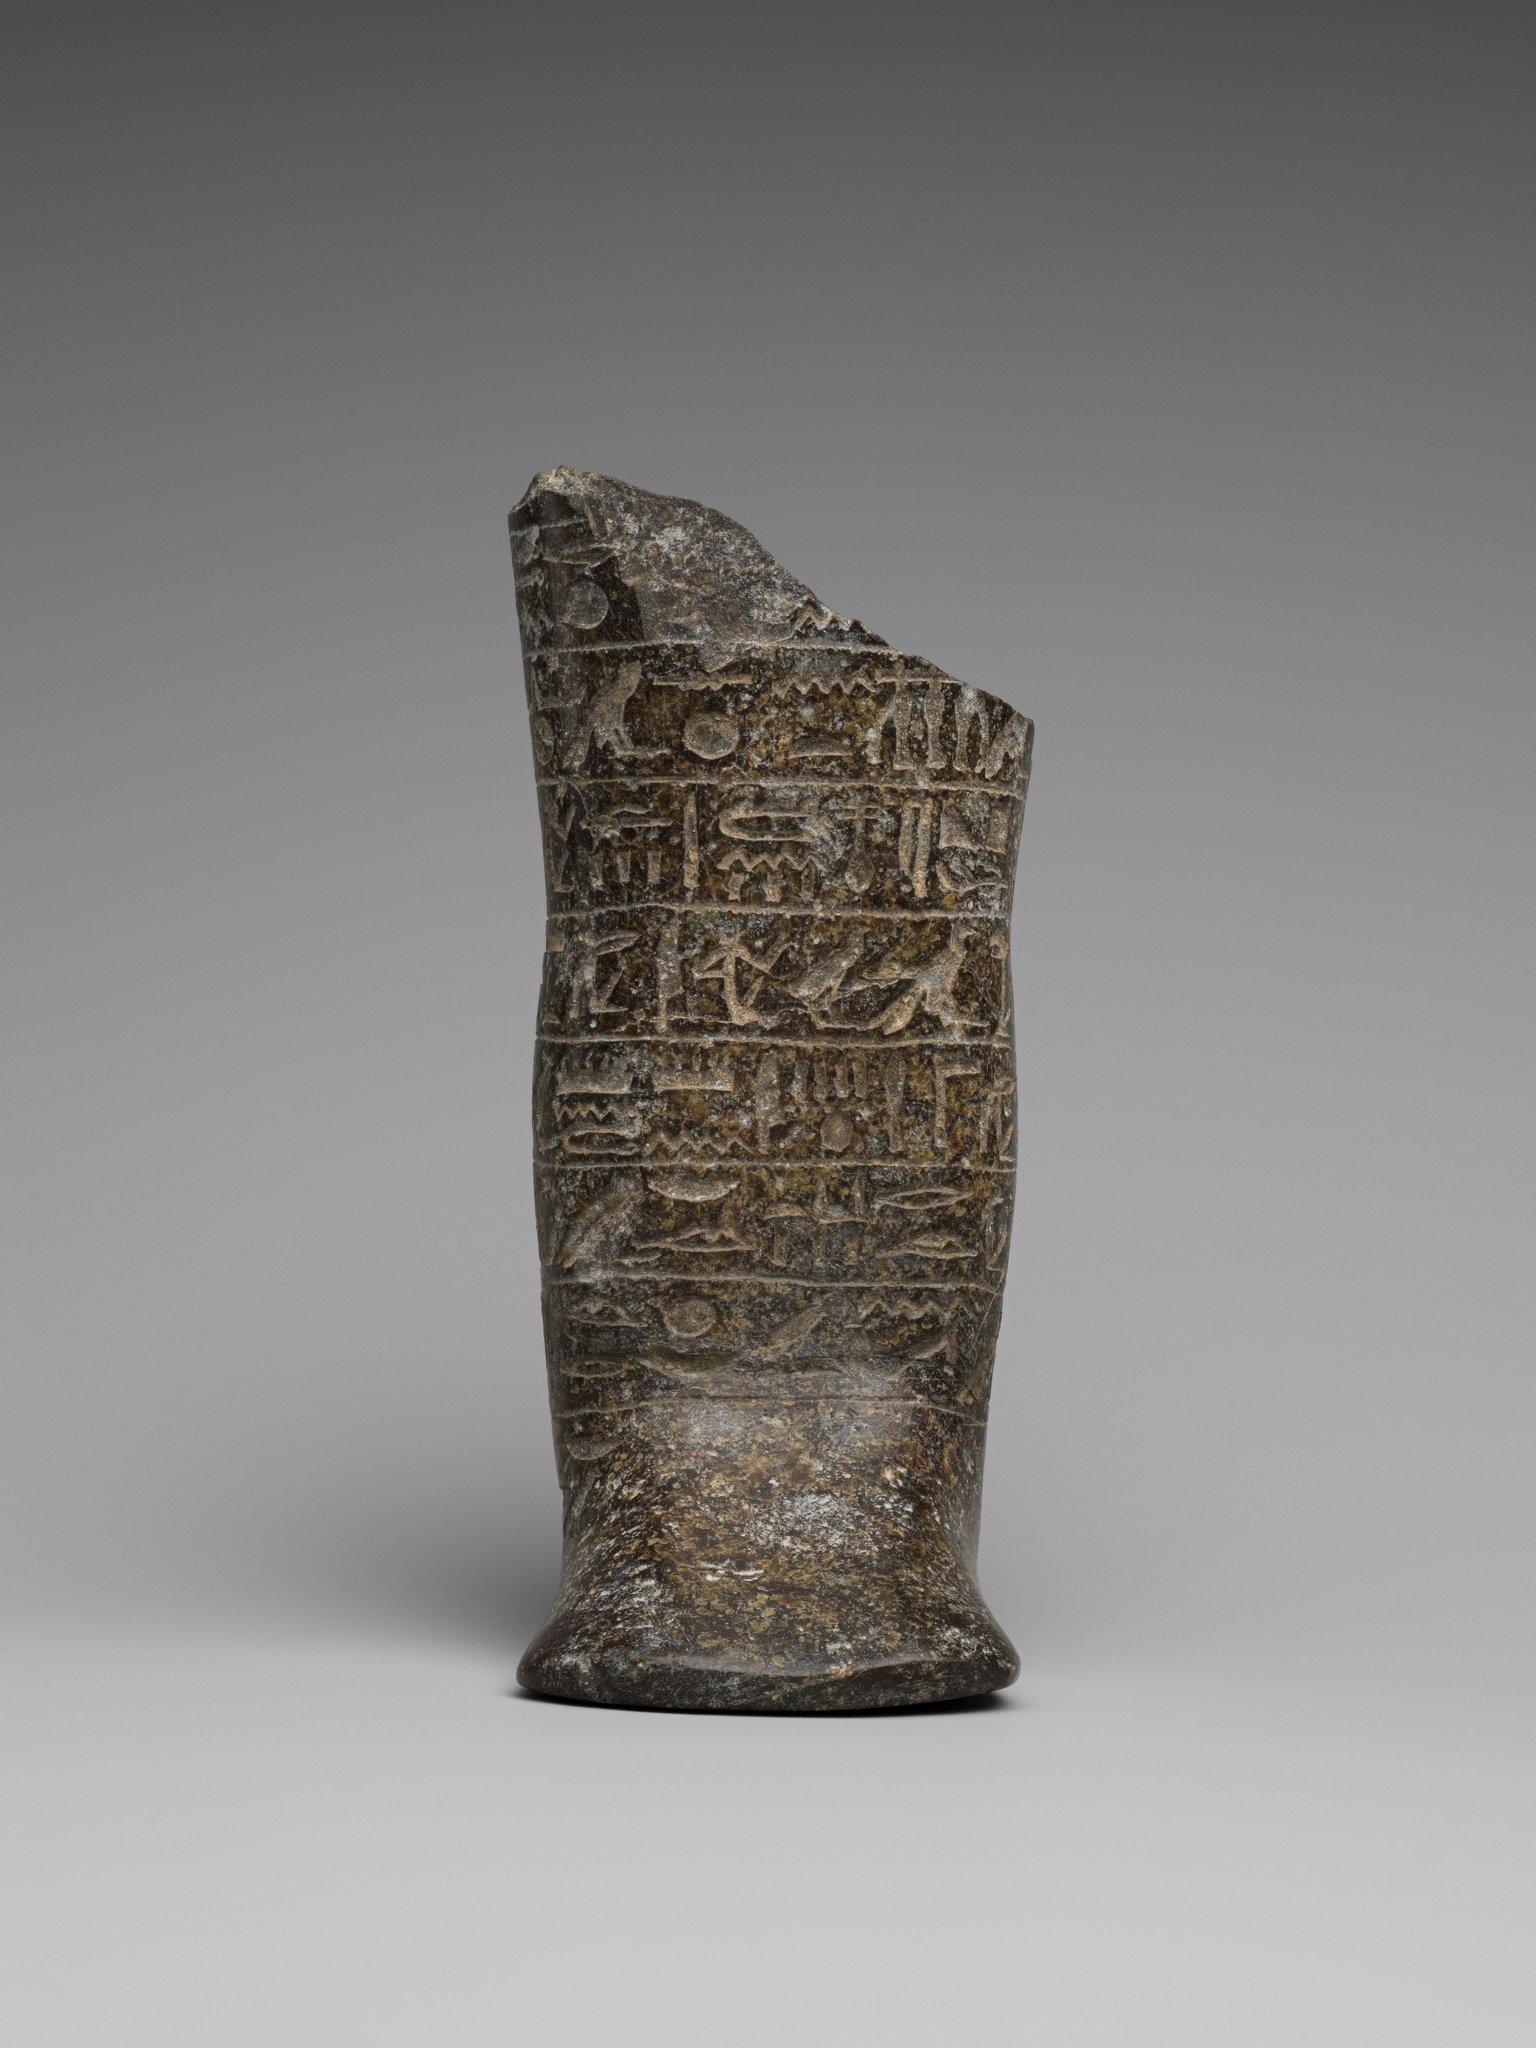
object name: shabti, mentuemhat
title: Shabti of Mentuemhat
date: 690-645 BCE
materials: stone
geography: egypt